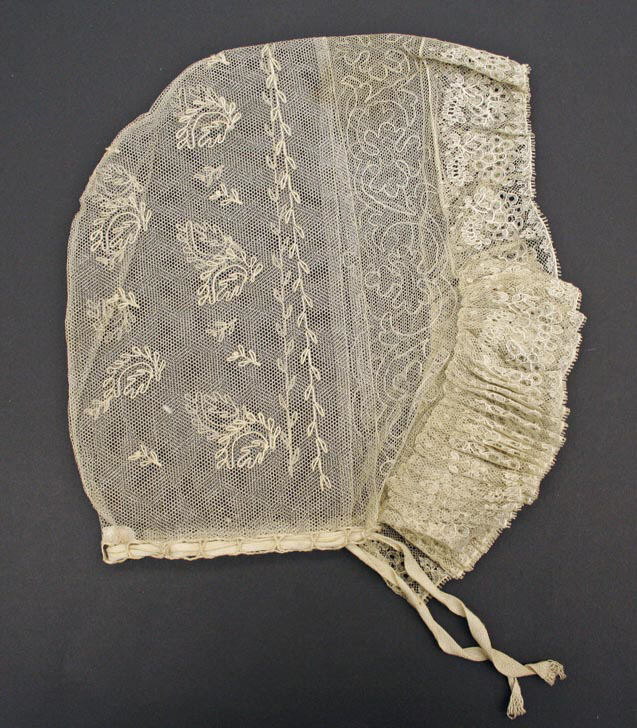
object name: cap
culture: french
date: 1801-1900